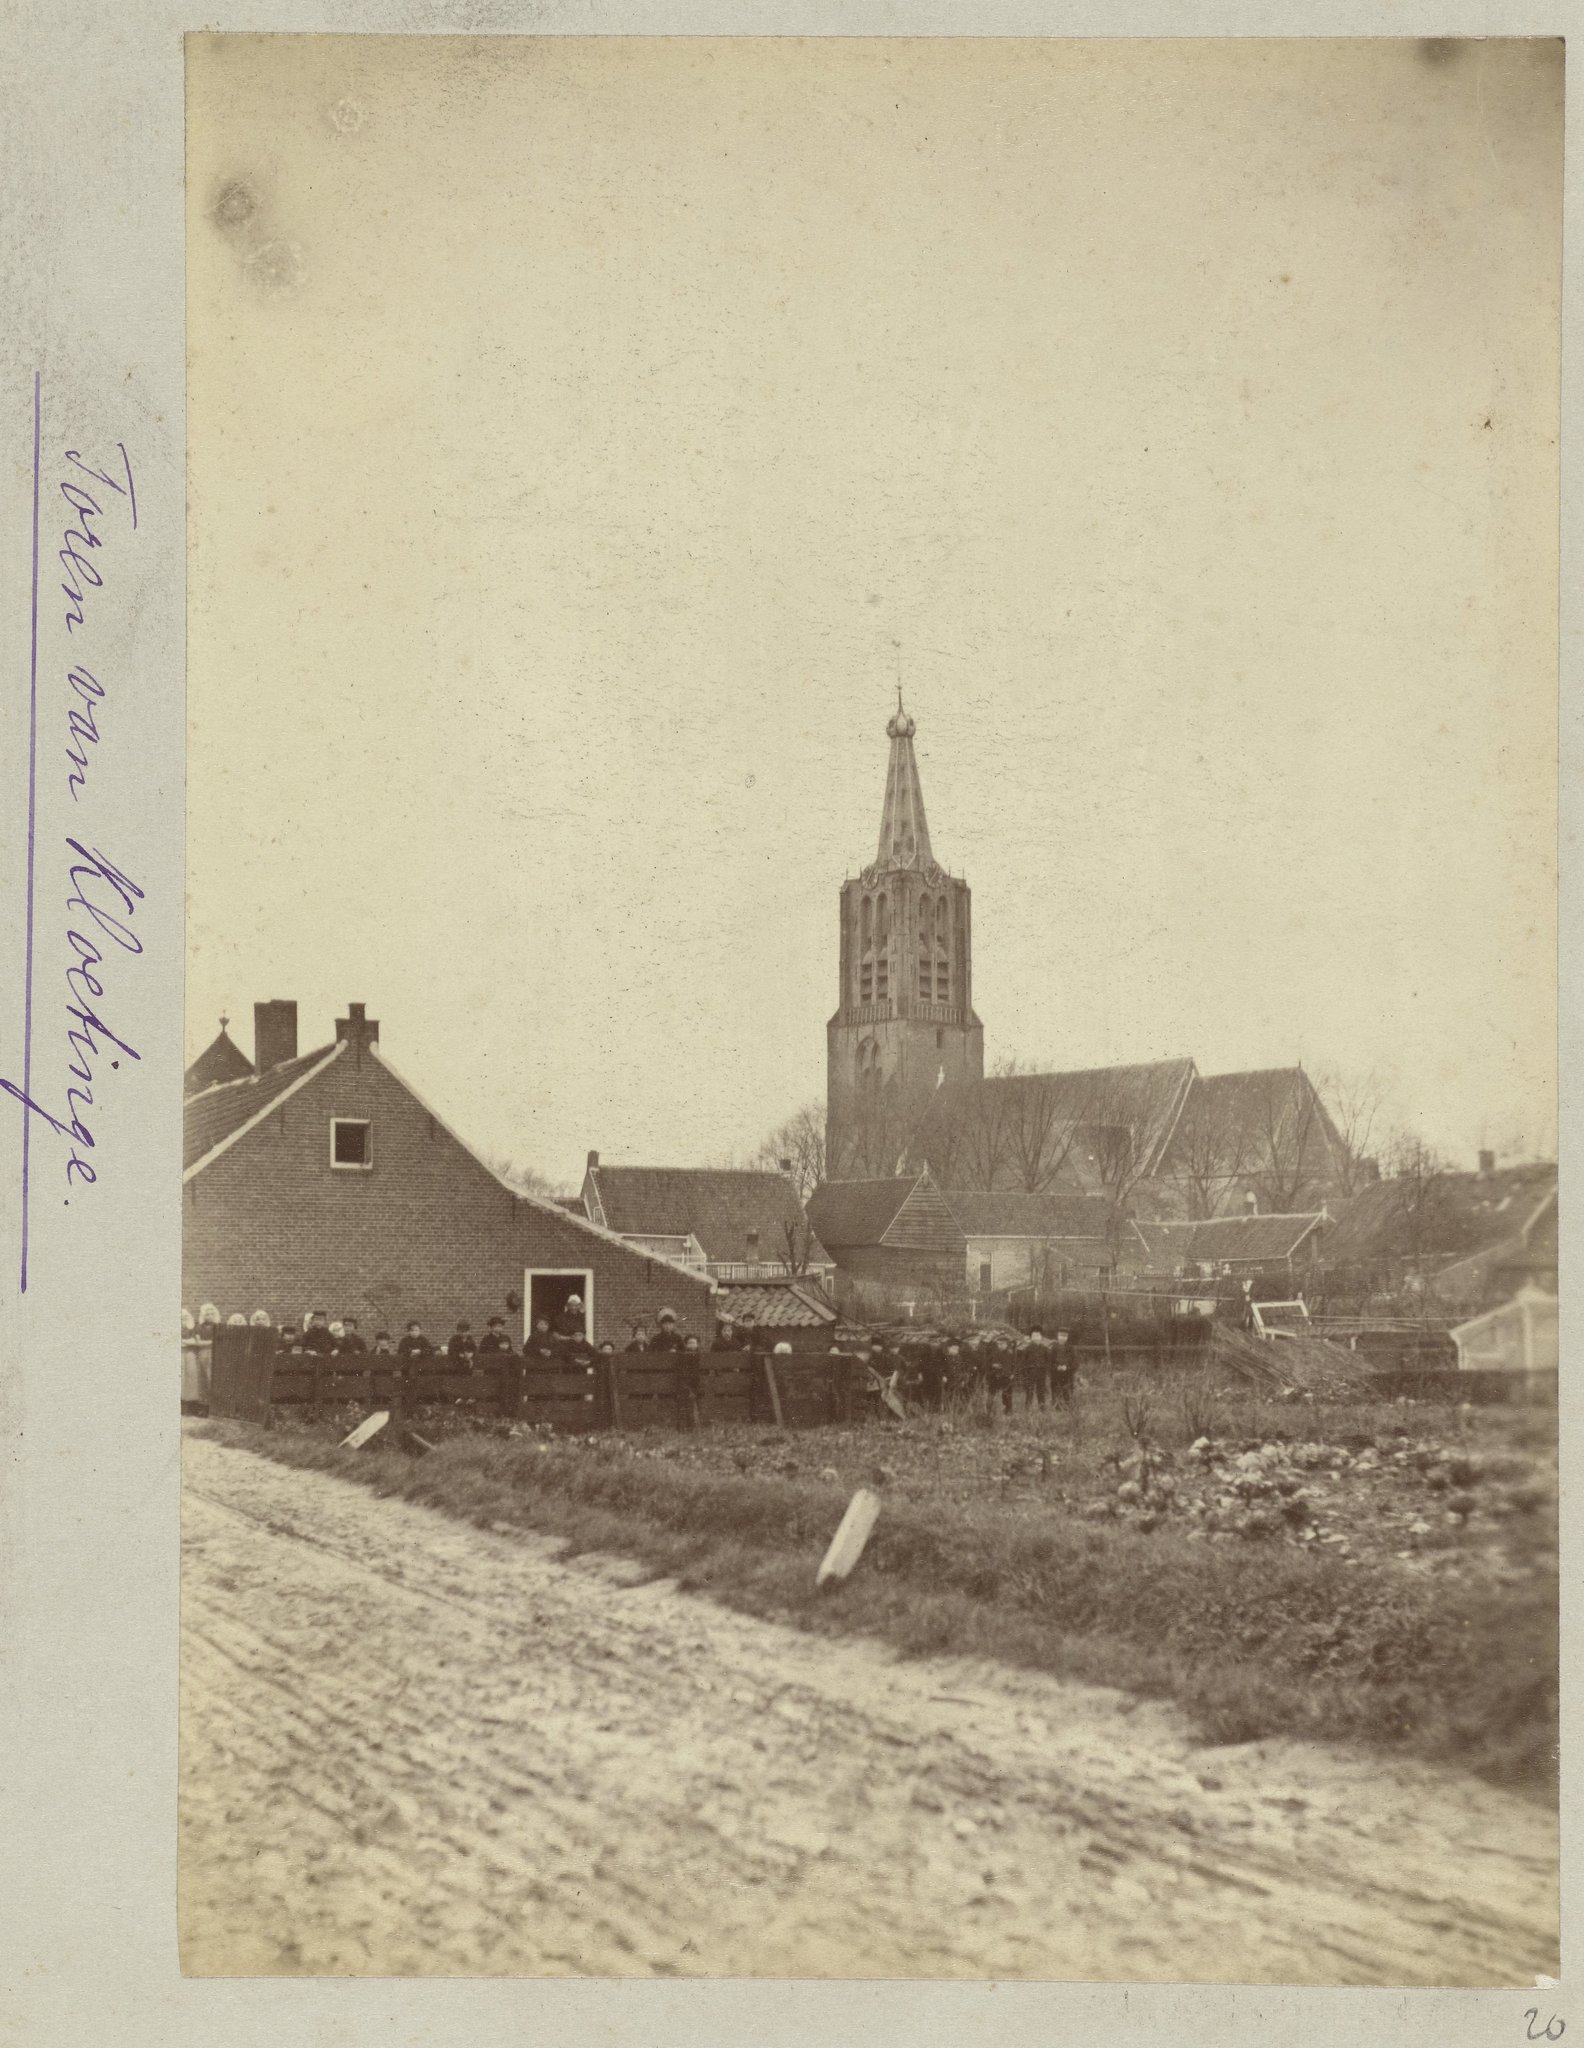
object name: photograph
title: Groepsportret van kinderen in Zeeuwse klederdracht, Kloetinge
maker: henry pauw van wieldrecht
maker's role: fotograaf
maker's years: 1863-1912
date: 1888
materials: paper, photographic support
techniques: albumen print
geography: netherlands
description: Een boerderij met achter het hek een tiental kinderen in Zeeuwse klederdracht, op de achtergrond de kerktoren van Kloetinge. Met onderschrift: Toren van Kloetinge.